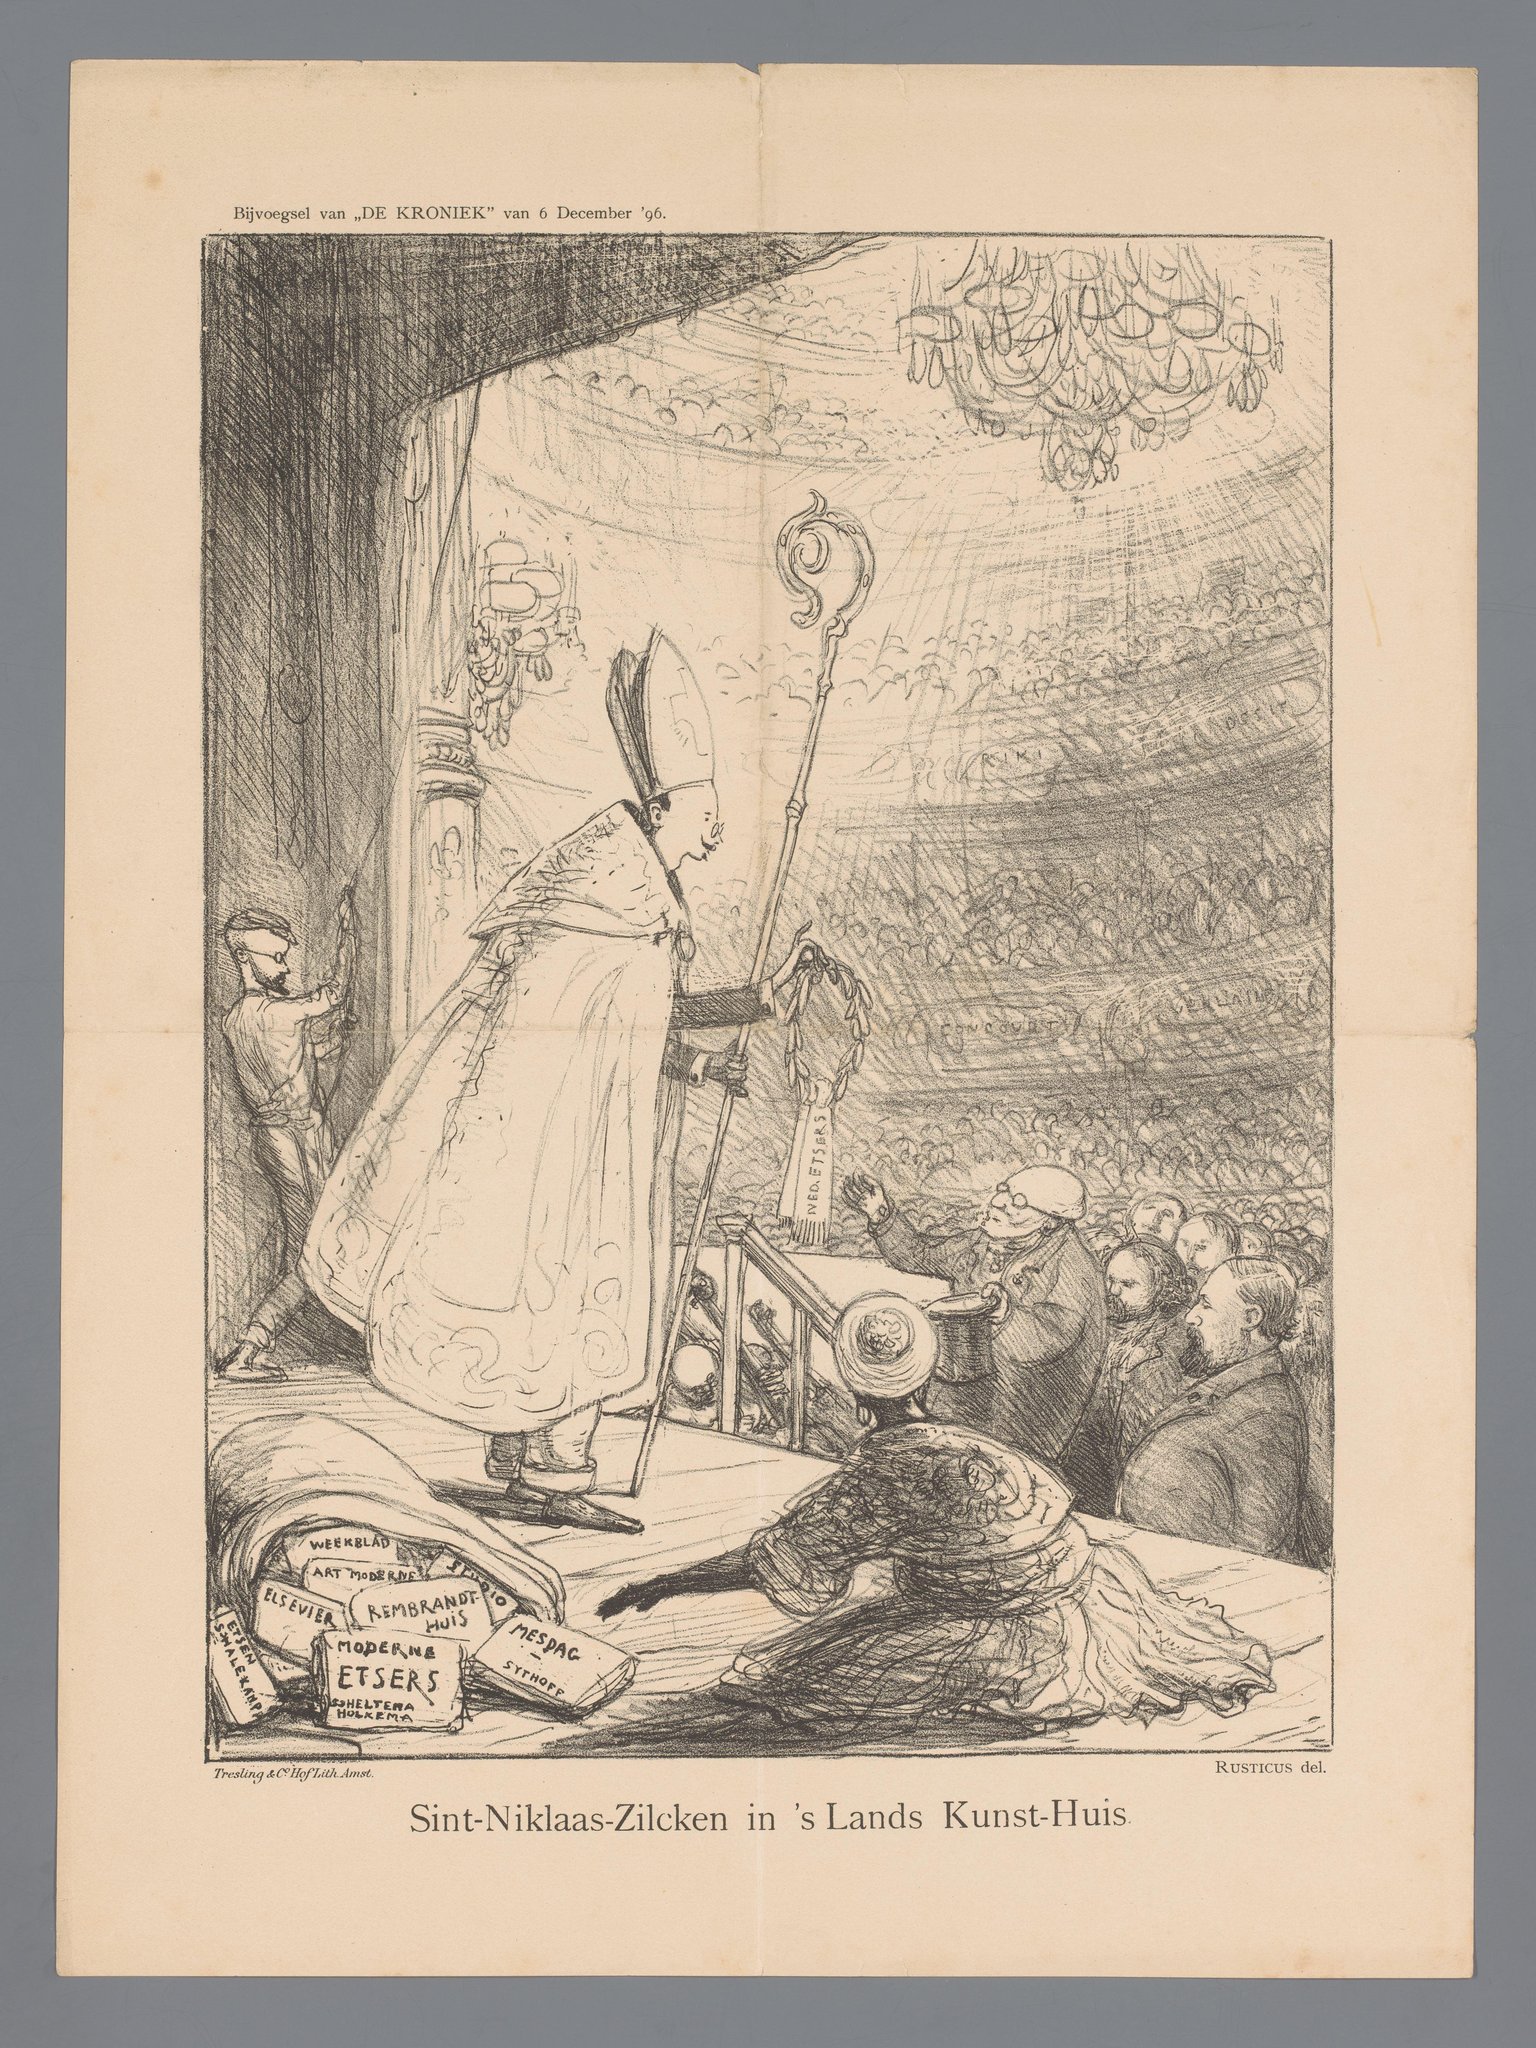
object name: cartoon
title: Sint-Niklaas-Zilcken in 's Lands Kunst-Huis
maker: marius bauer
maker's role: draughtsman, print maker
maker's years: 1867-1932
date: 1896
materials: paper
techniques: lithograph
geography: netherlands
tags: dordrecht, amsterdam, print maker, designer, jan veth, the hague, painter, draughtsman, philip zilcken, archbishop, bishop, etc. (roman catholic), the graphic arts, festivities on st. nicholas (eve) (december 5), graphic artist, netherlands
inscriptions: date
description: Spotprent op Philip Zilcken naar aanleiding van het verschijnen van zijn boek over Moderne Hollandsche Etsers in 1896. Zilcken voorgesteld als Sinterklaas die staande op een toneel cadeautjes uitdeelt, links houdt Jan Veth het gordijn op. Verschenen in de bijvoegsel van 'De Kroniek' van 6 december 1896.